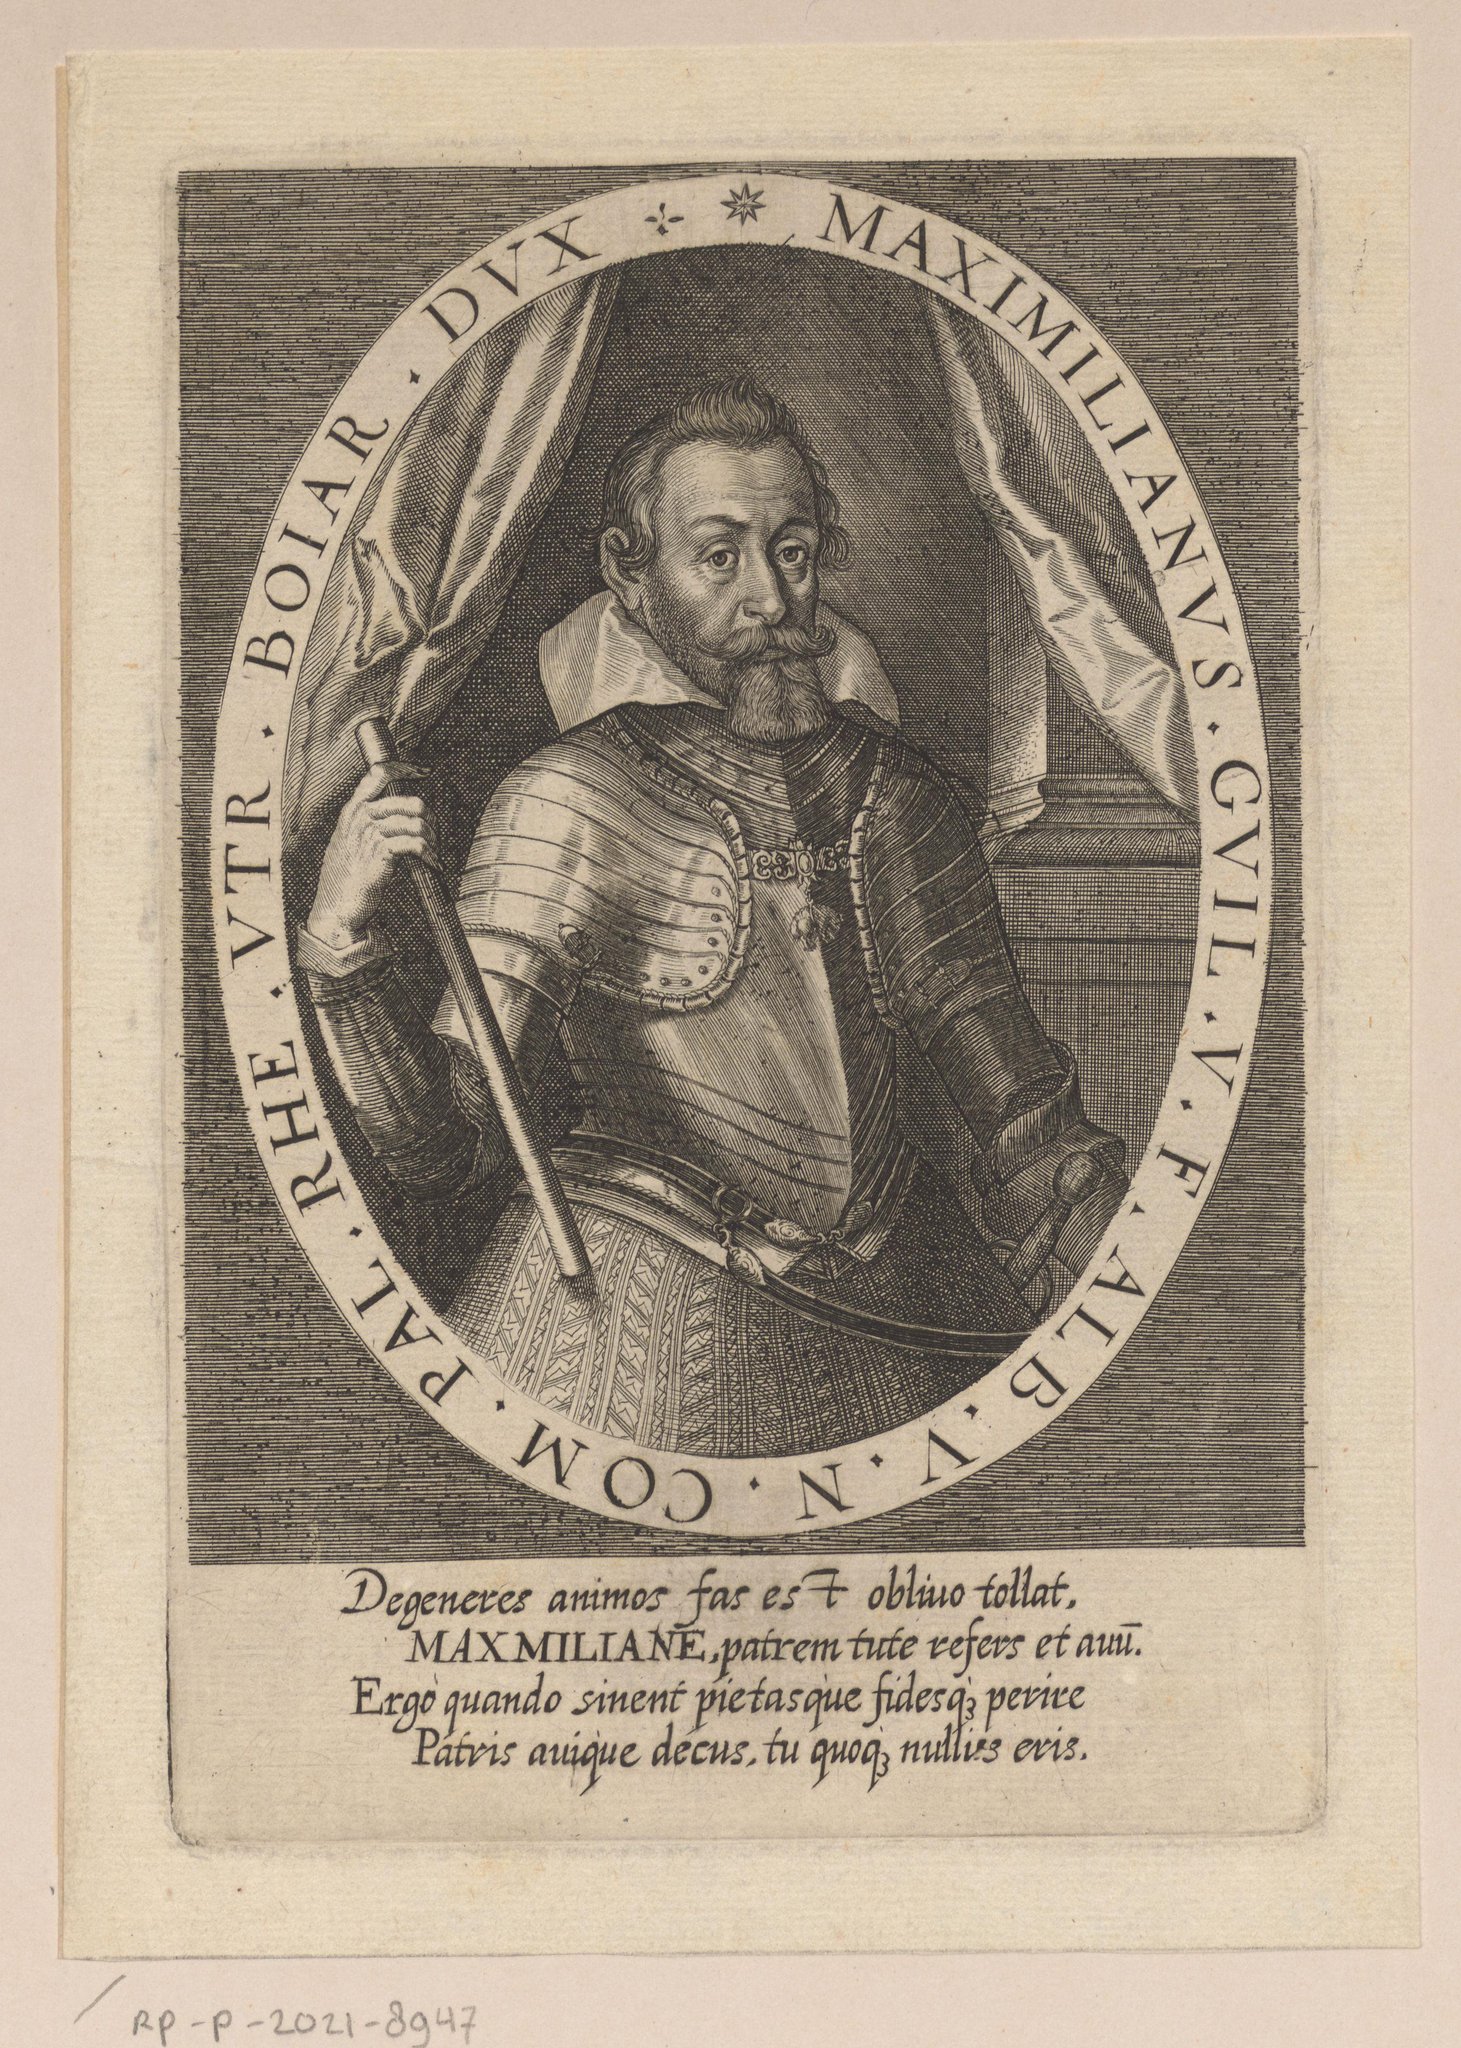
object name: print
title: Portret van Maximiliaan I van Beieren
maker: wolfgang kilian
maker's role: print maker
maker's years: 1581-1662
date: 1620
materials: paper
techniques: engraving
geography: augsburg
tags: maximiliaan i (keurvorst van beieren), armour, historical persons, knighthood order of the golden fleece - insignia of a knighthood order, e.g.: badge, chain (with name of order)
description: Prent met tekst in boekdruk op verso gebruikt in: Genealogia Serenissimor. Boiariae Ducum et Quorundam Genuinae Effigies. S.l.s.n., 1620.